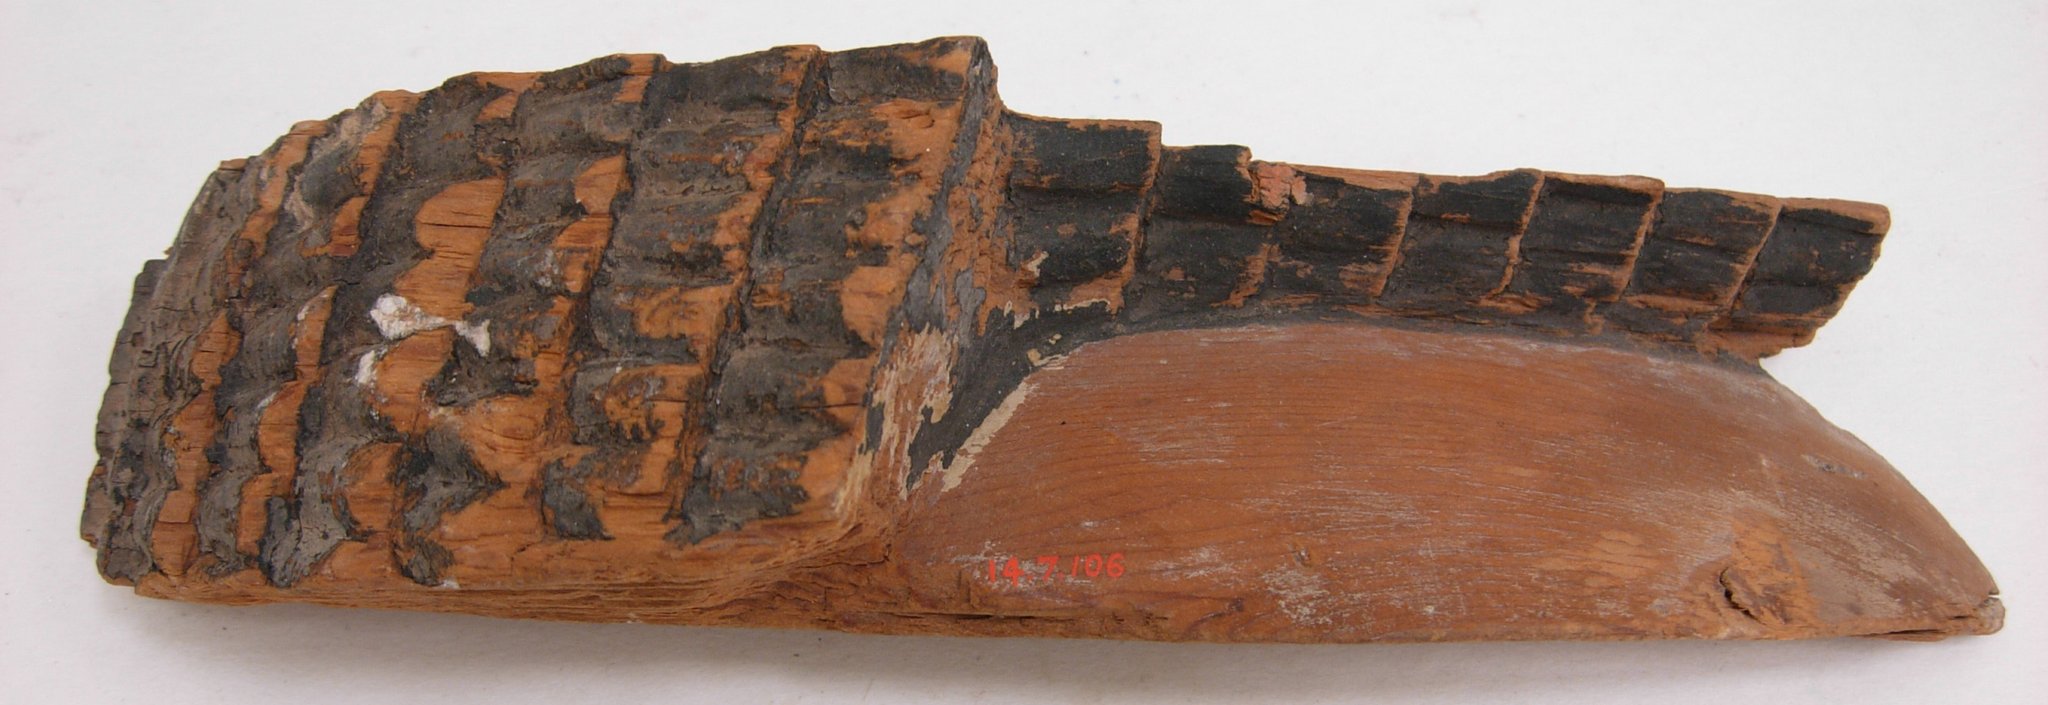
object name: head fragment, perneb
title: Fragment from the head of a statue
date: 2381-2323 BCE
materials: paint, wood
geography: egypt